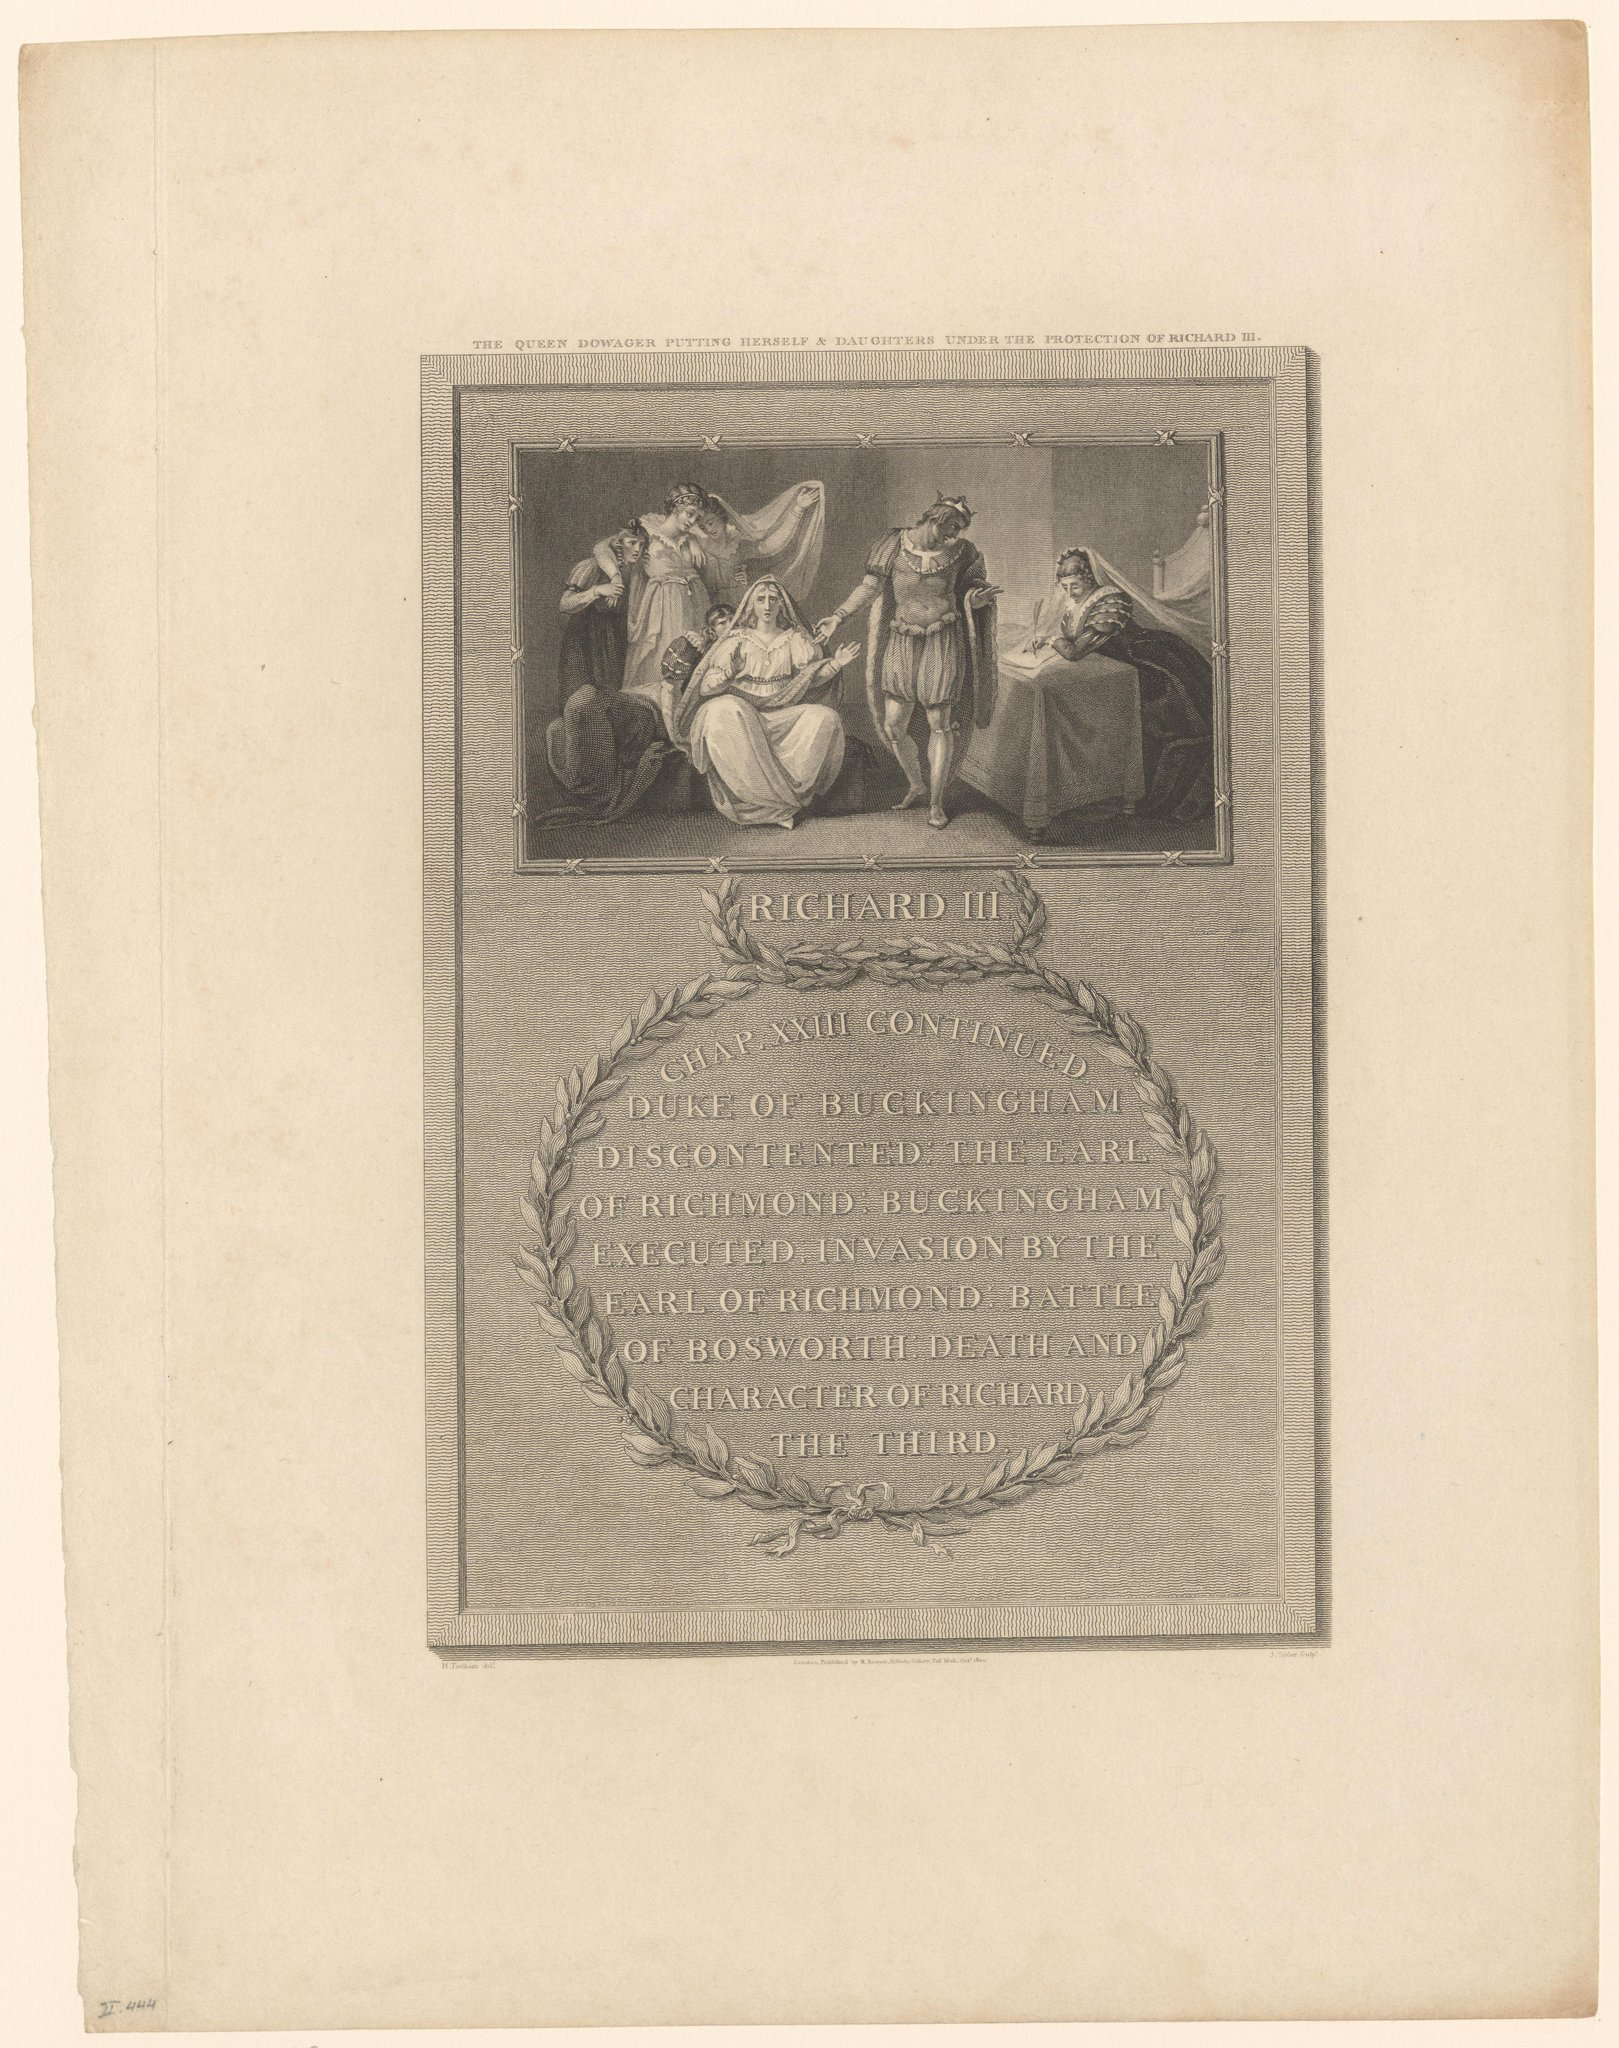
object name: print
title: The Historic Gallery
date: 1800-1810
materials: paper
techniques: etching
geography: london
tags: london, historical persons, king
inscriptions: collector's mark: Lugt 2228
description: De prenten uit deze serie zijn naar schilderijen uit Bowyer's Historic Gallery. Deze schilderijen en tekeningen illustreerden de gebeurtenissen uit David Hume's History of England. De prenten zijn daarom mogelijk gebruikt als illustratie in deze boeken.